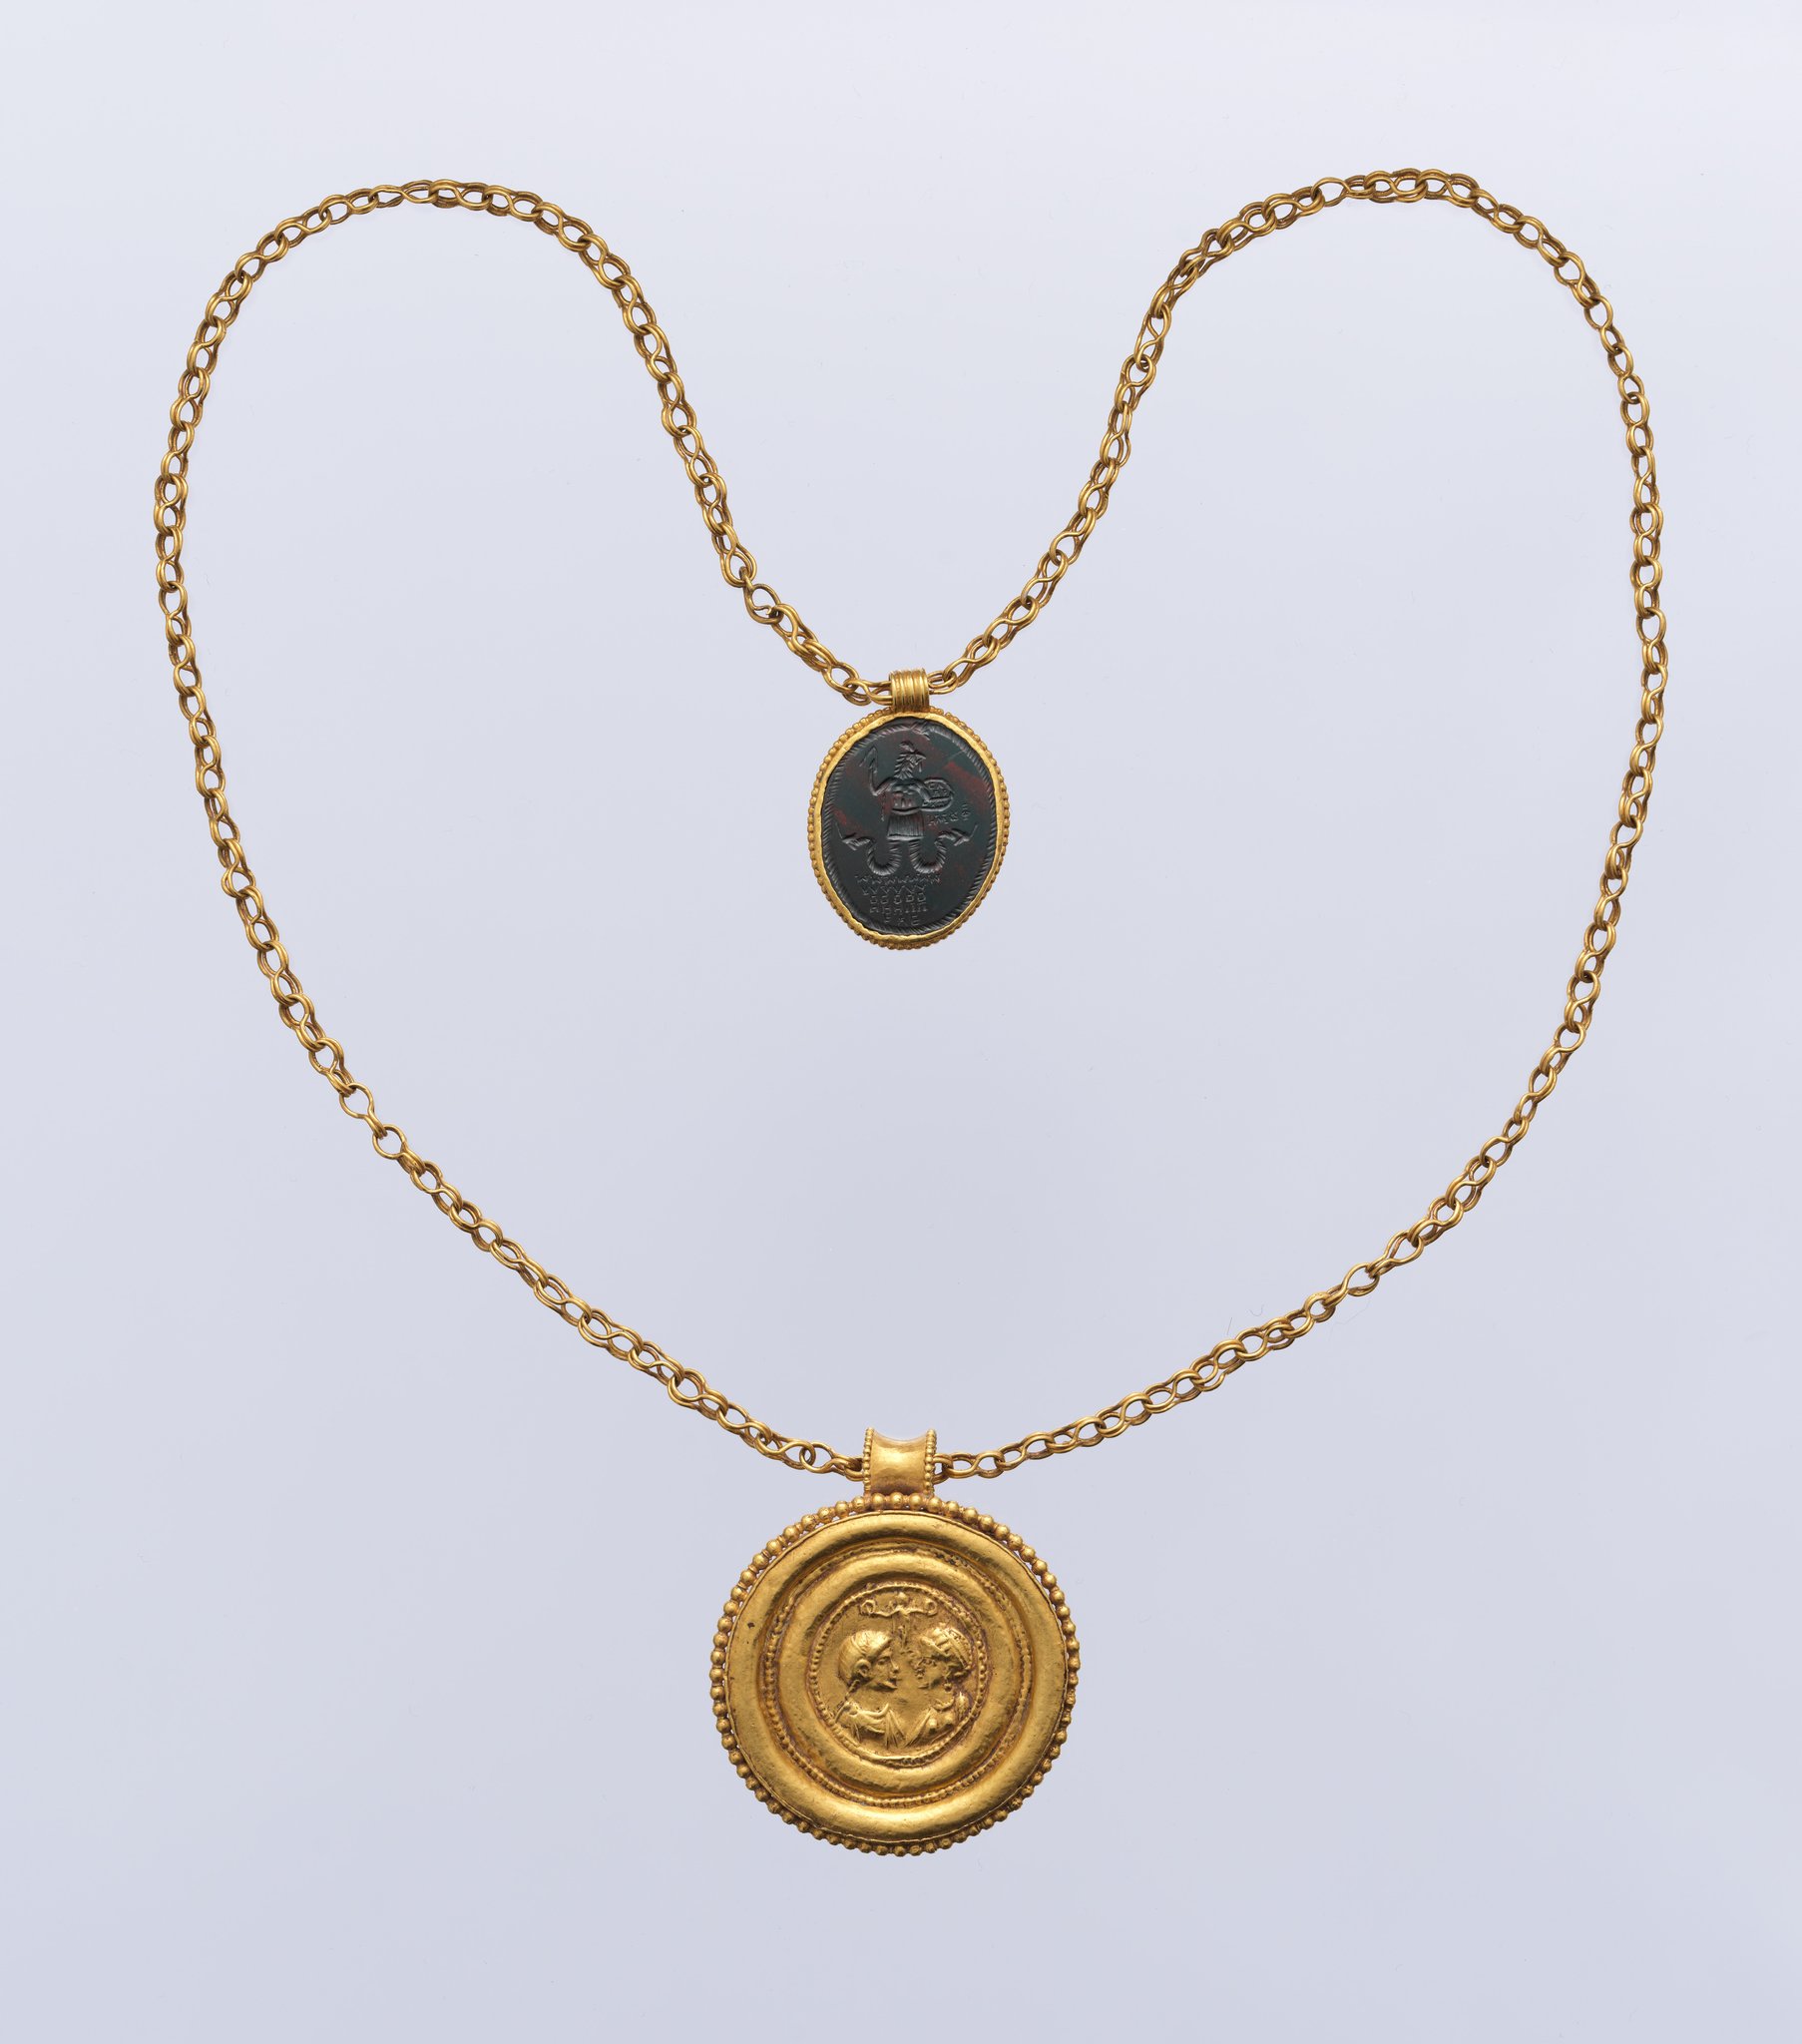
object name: necklace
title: Necklace with Gold Marriage Medallion and Hematite Amulet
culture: byzantine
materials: gold, mineral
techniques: repoussé